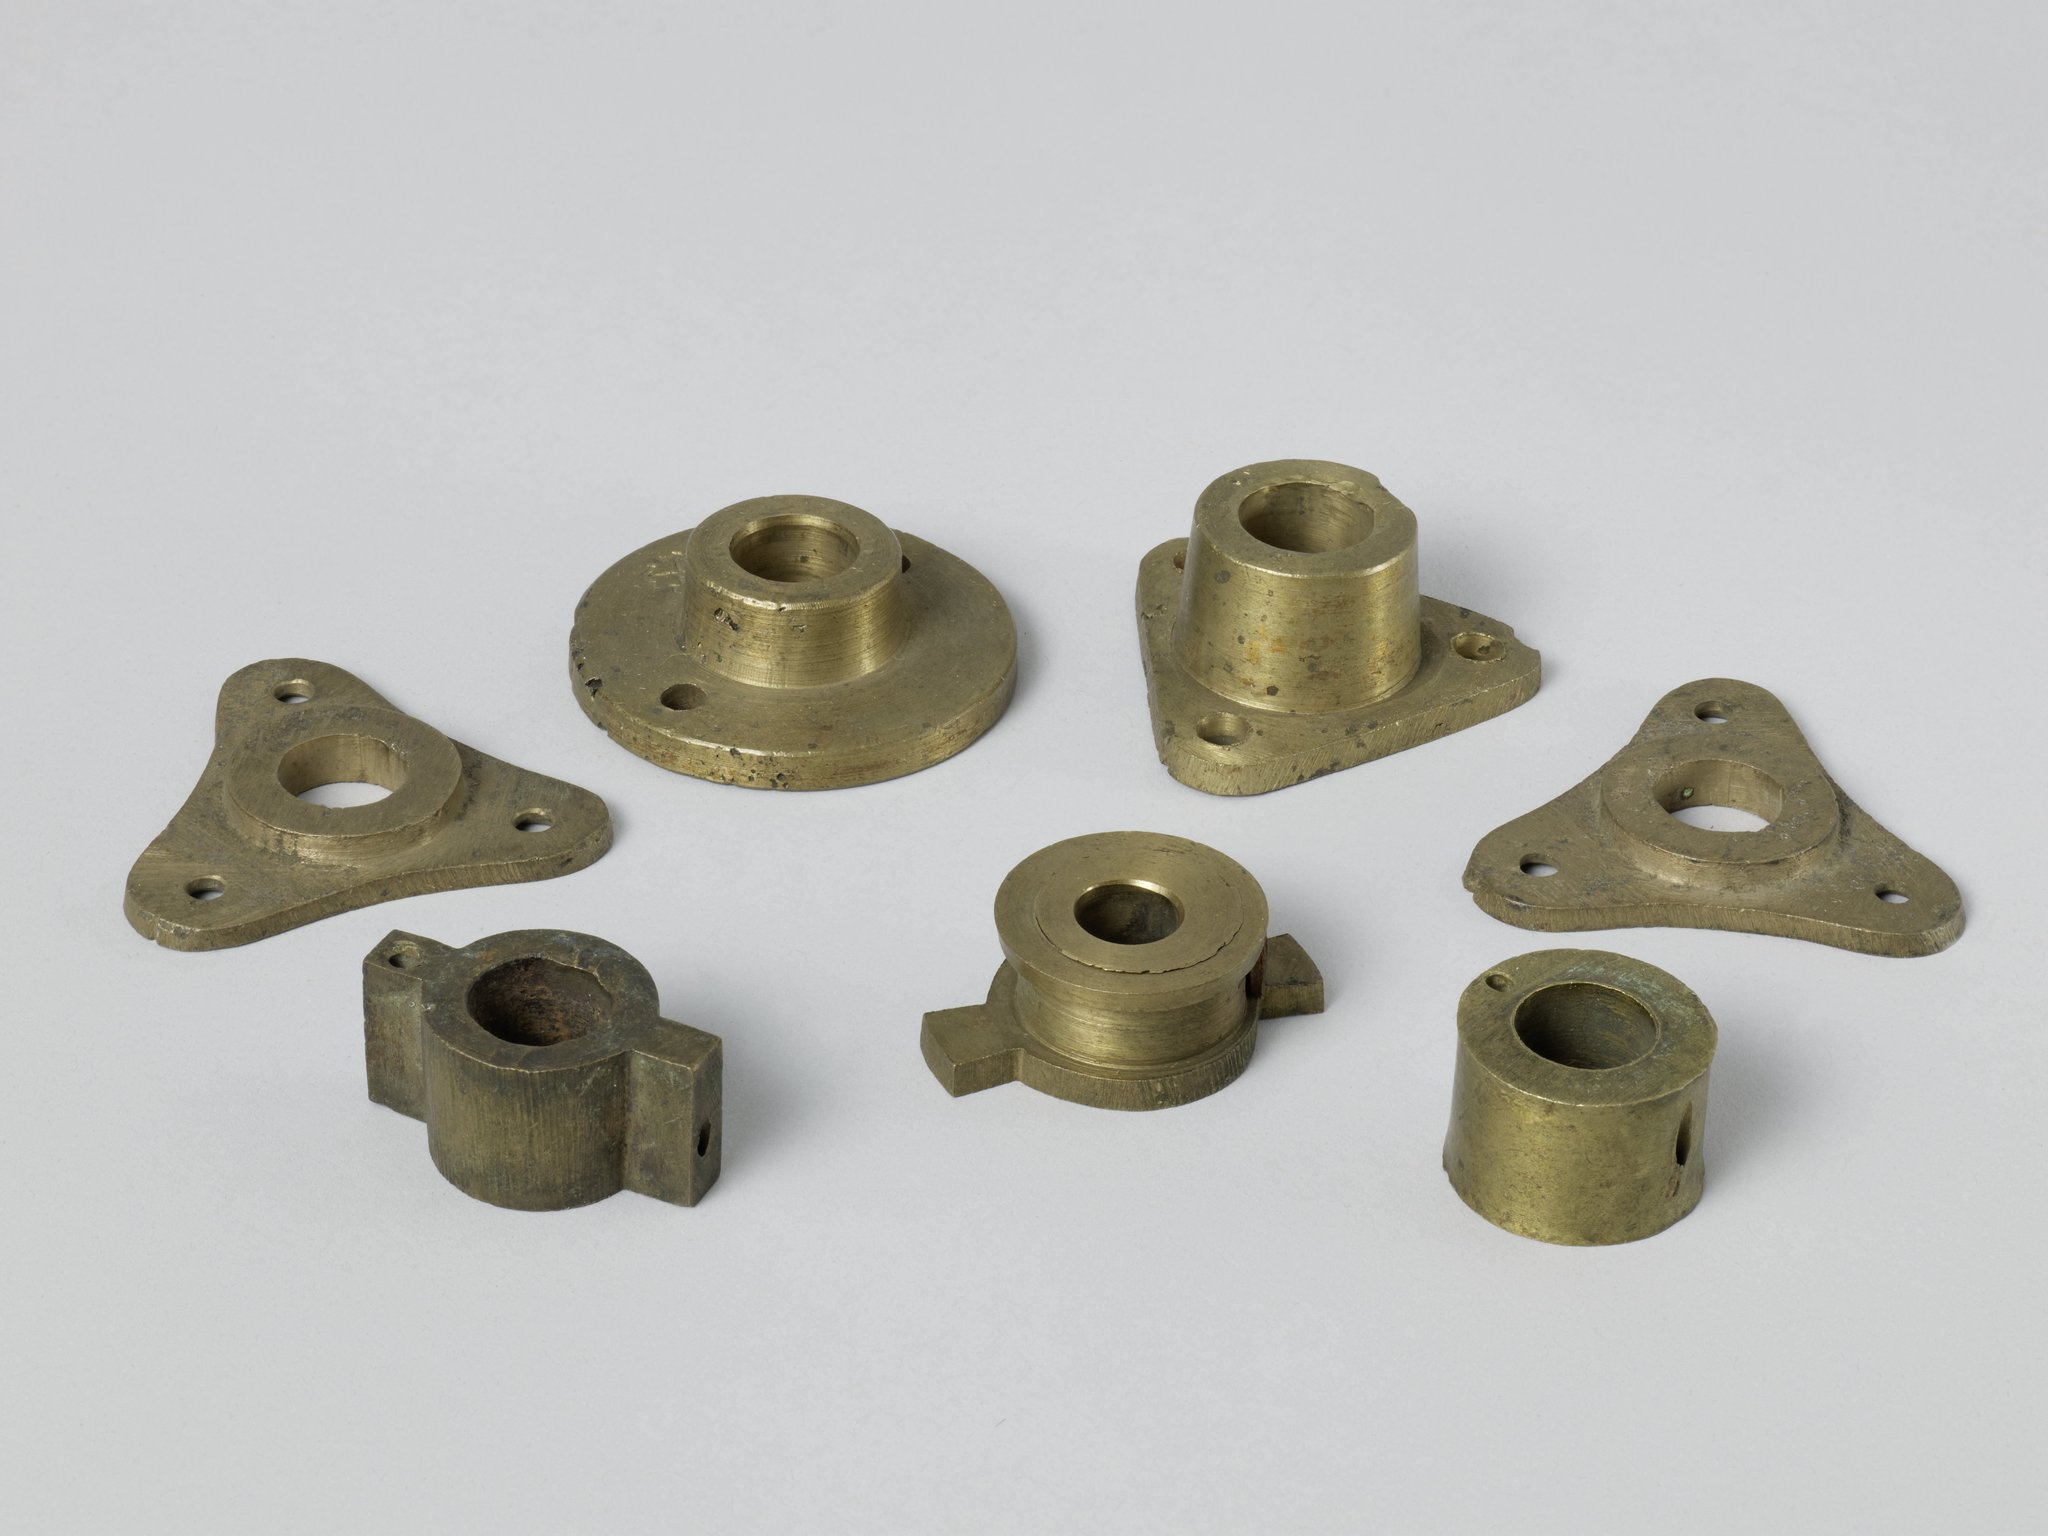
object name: blokschijf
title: Seven Brass Coaks for Sheaves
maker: Anonymous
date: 1850-1865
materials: brass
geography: netherlands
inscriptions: inscription: ‘V L’, monogram, on the large, round coak: crossed anchors